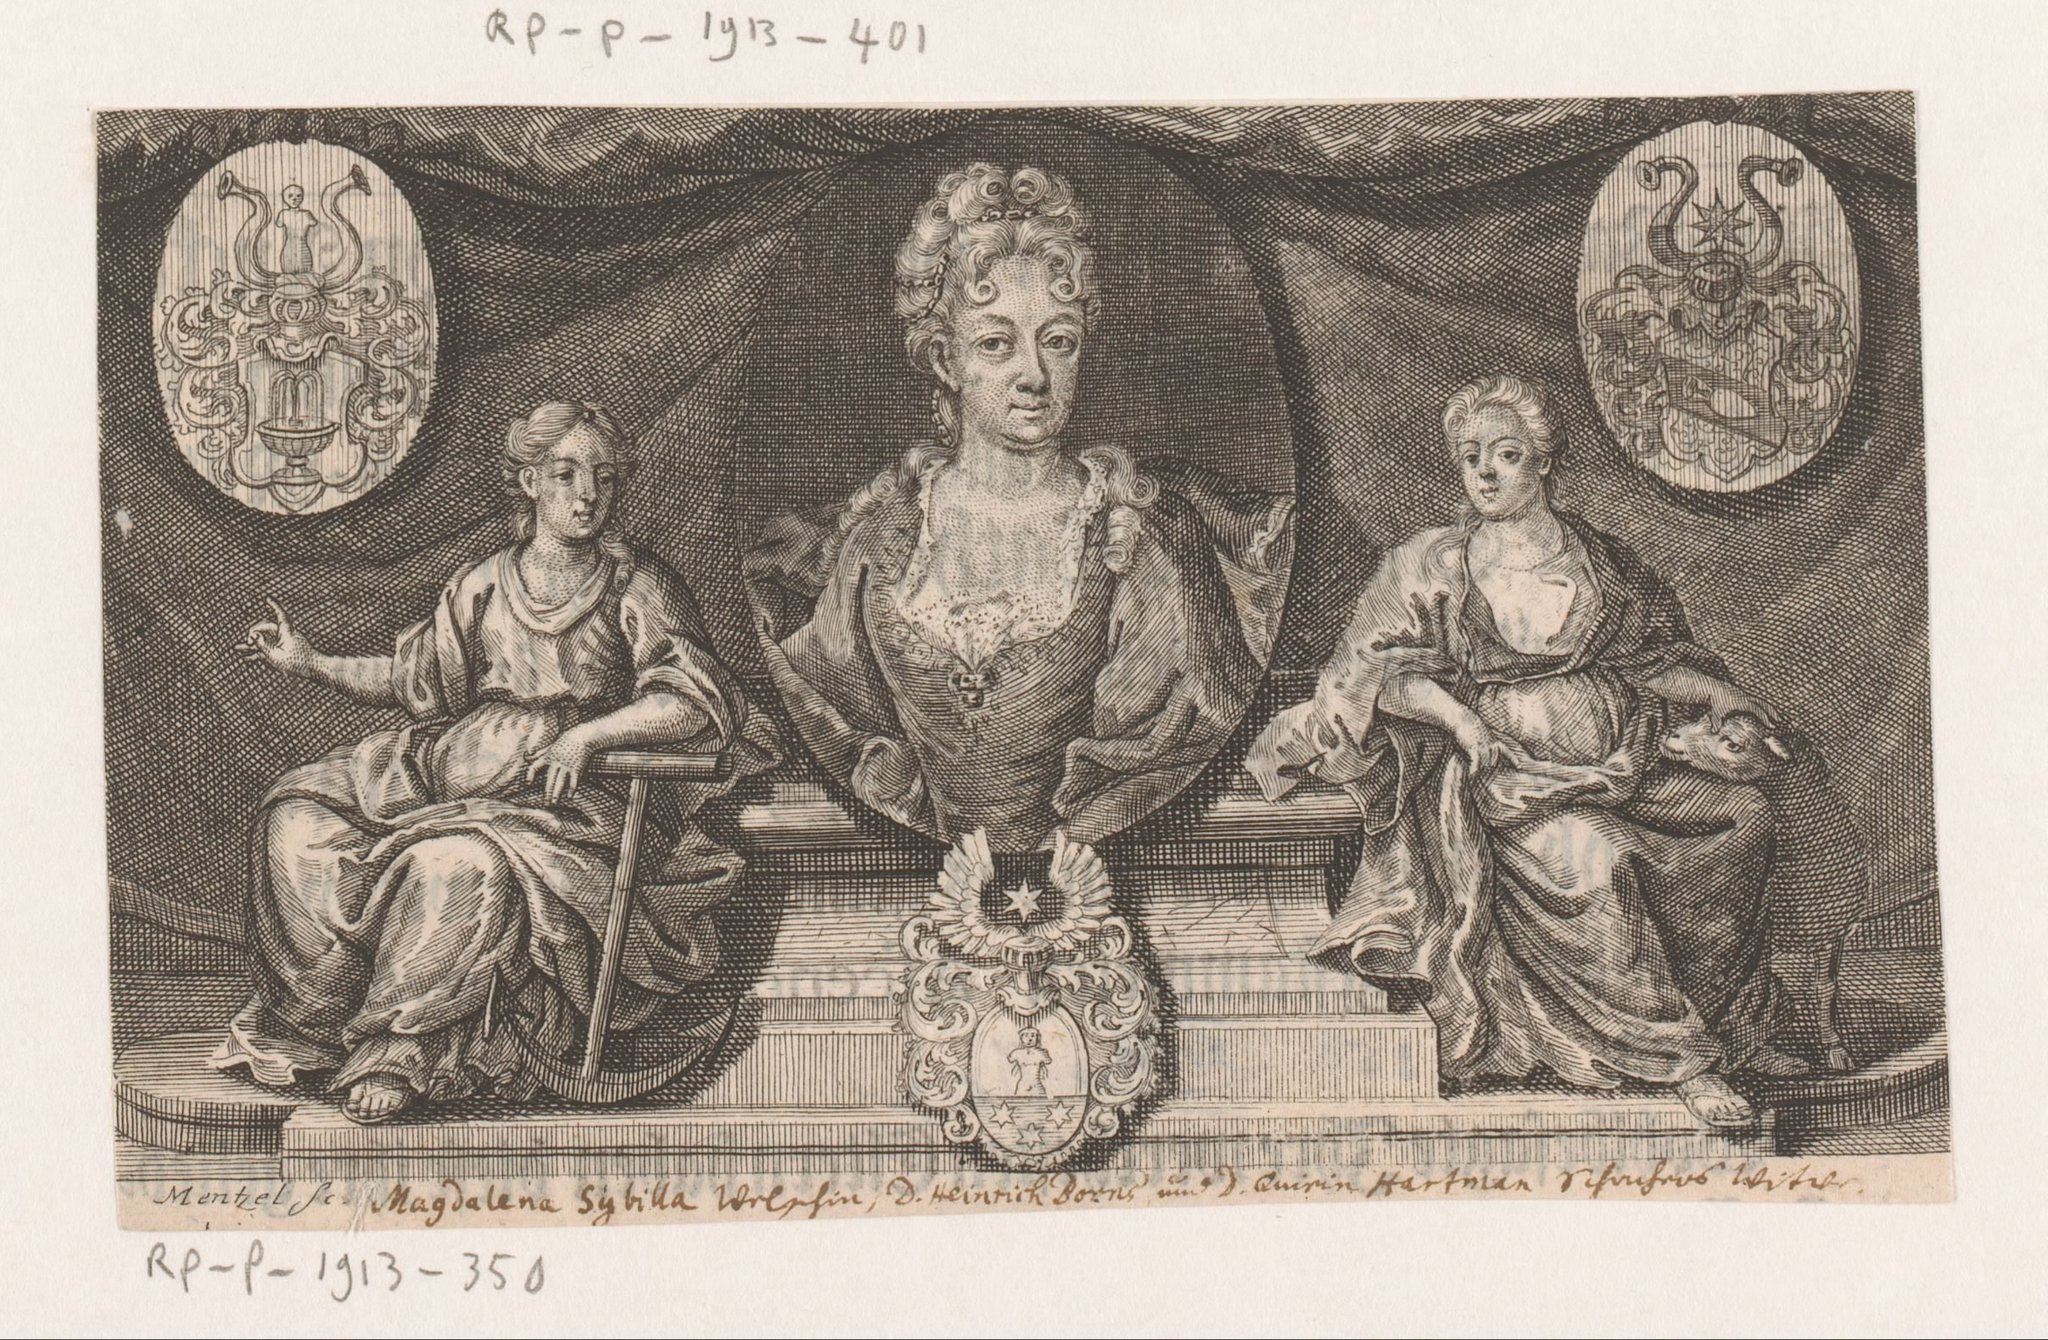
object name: print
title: Portret van Magdalena Sibylla Schacher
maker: johann georg mentzel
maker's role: print maker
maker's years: 1677-1743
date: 1687-1743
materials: paper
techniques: engraving, etching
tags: historical persons - bb - woman, sheep, parts of ship's exterior: anchor, armorial bearing, heraldry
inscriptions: inscription: ‘Magdalena Sybilla (?), D. Heinrich Borns (?) Quirin Hartman (?)’, collector's mark: Lugt 2228